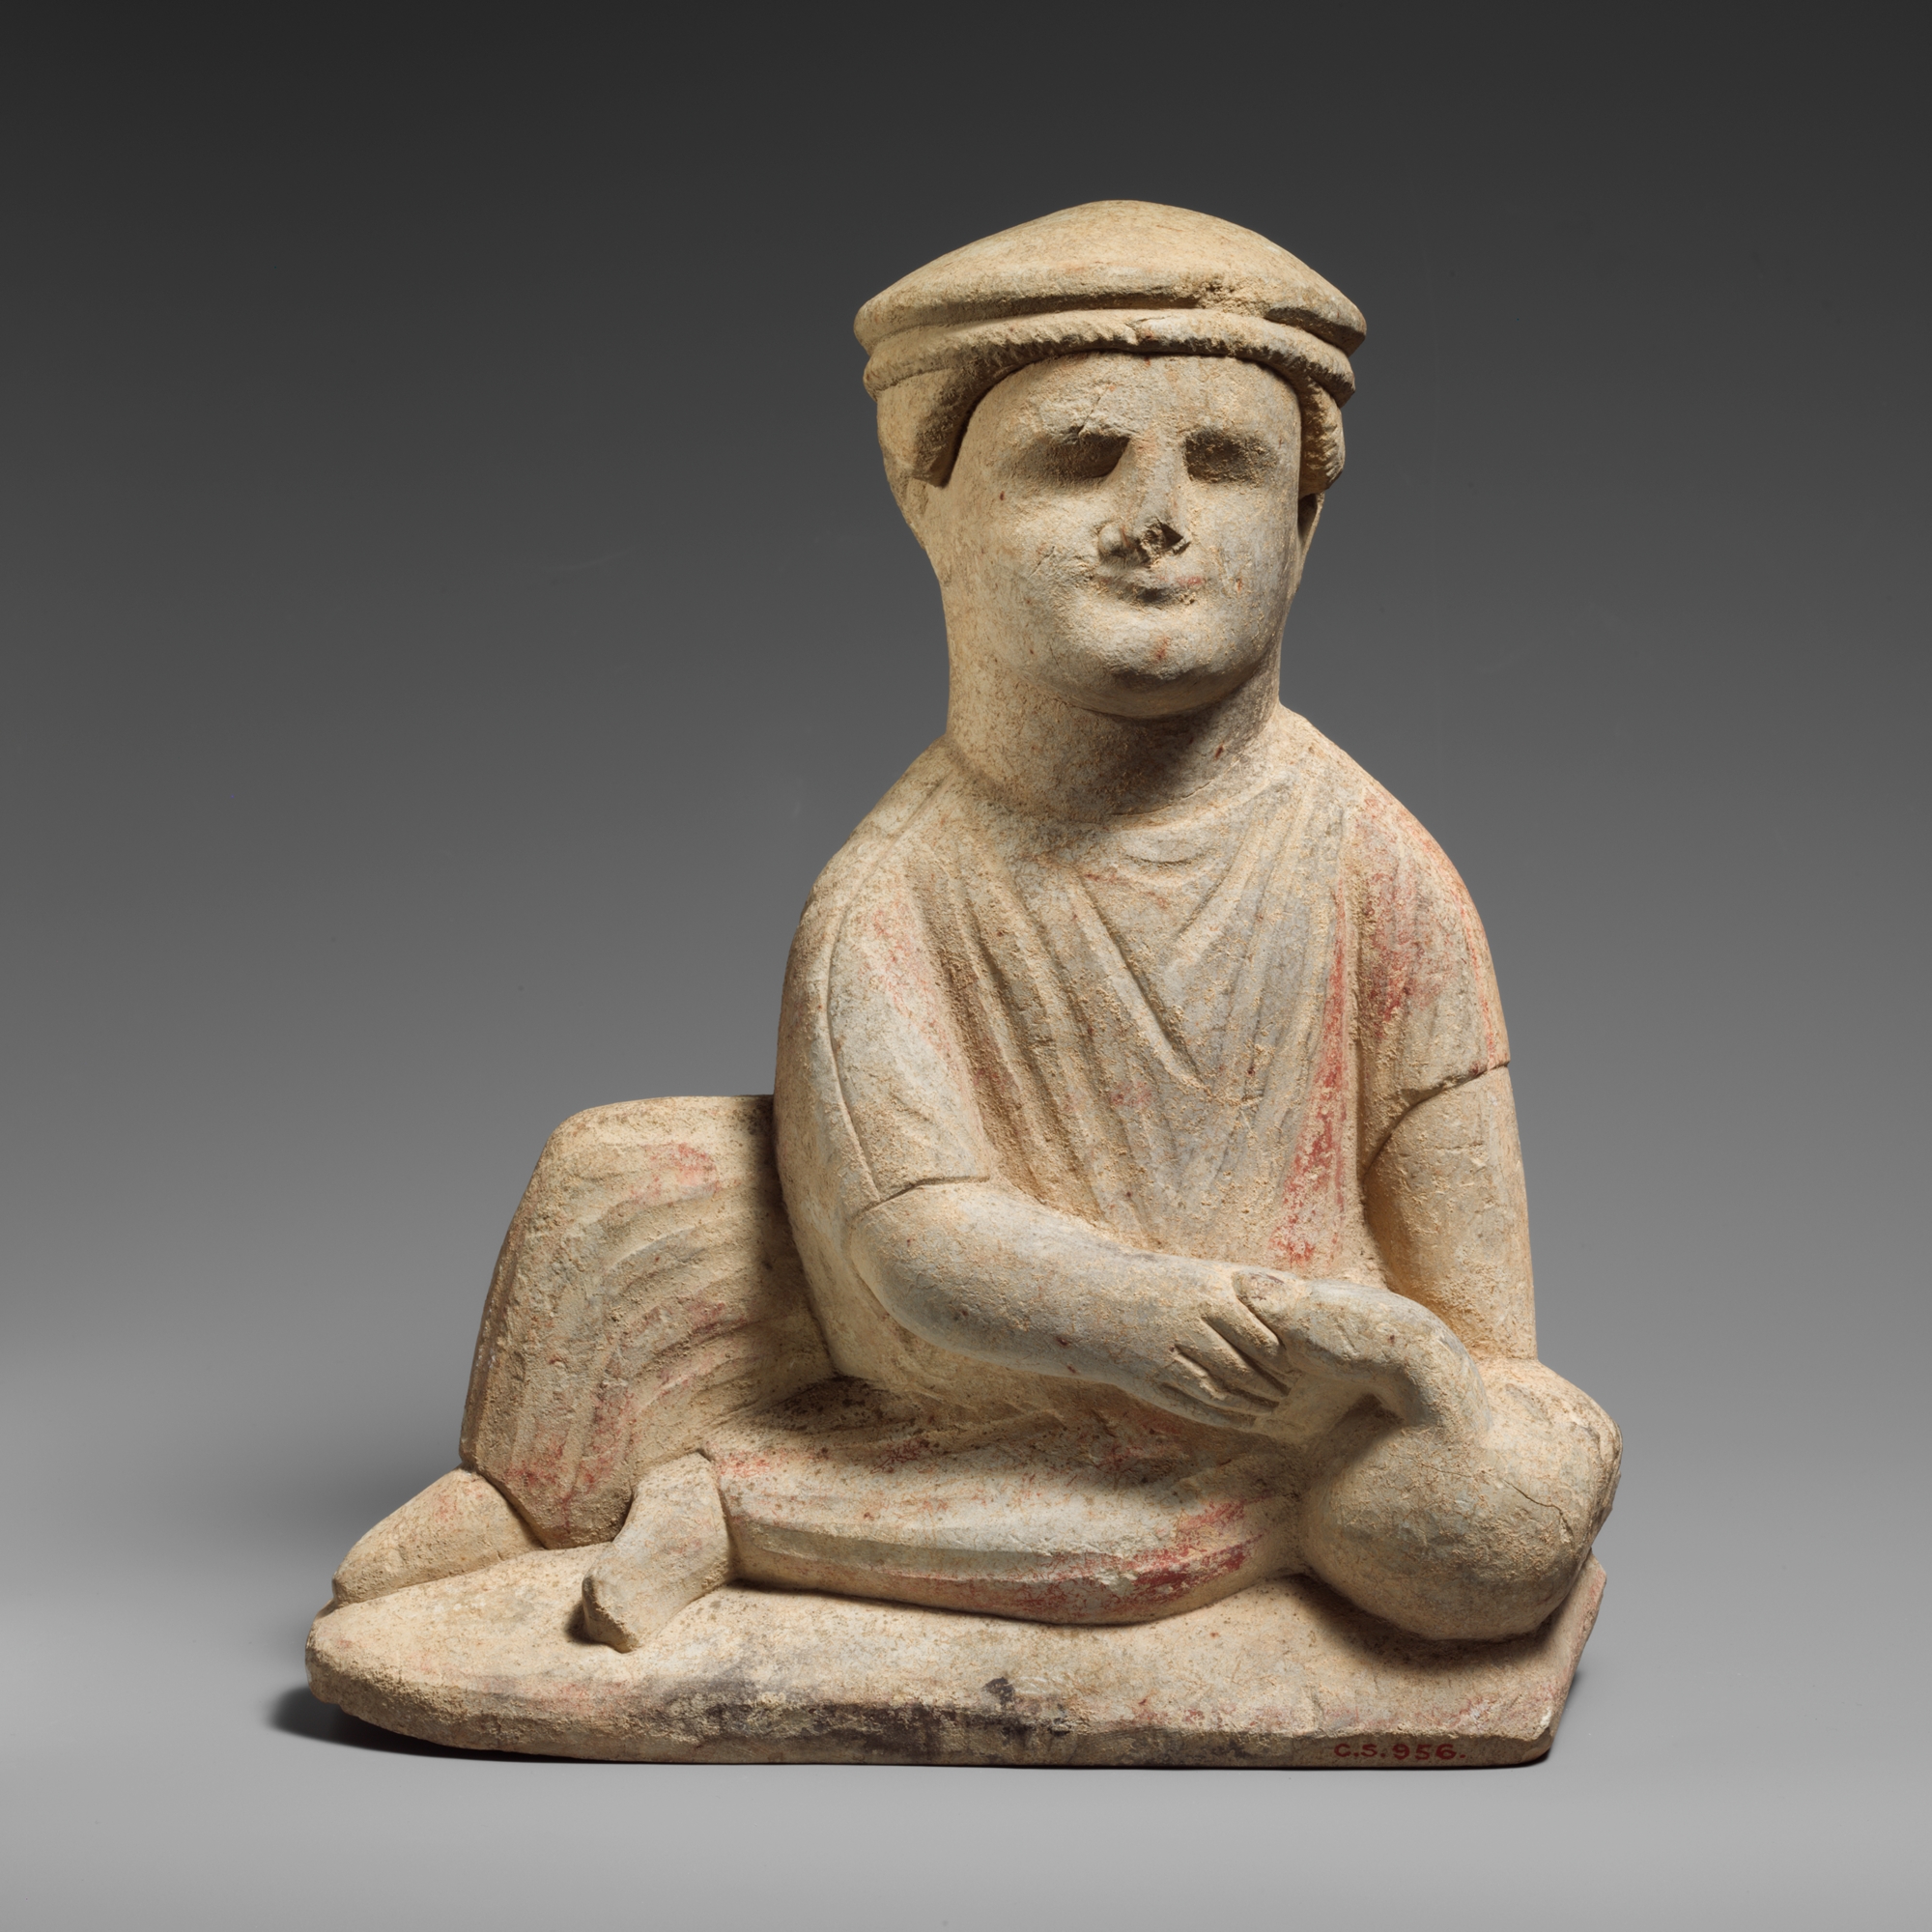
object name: statuette of a temple boy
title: Limestone statuette of a temple boy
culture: cypriot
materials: limestone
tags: ducks,boys